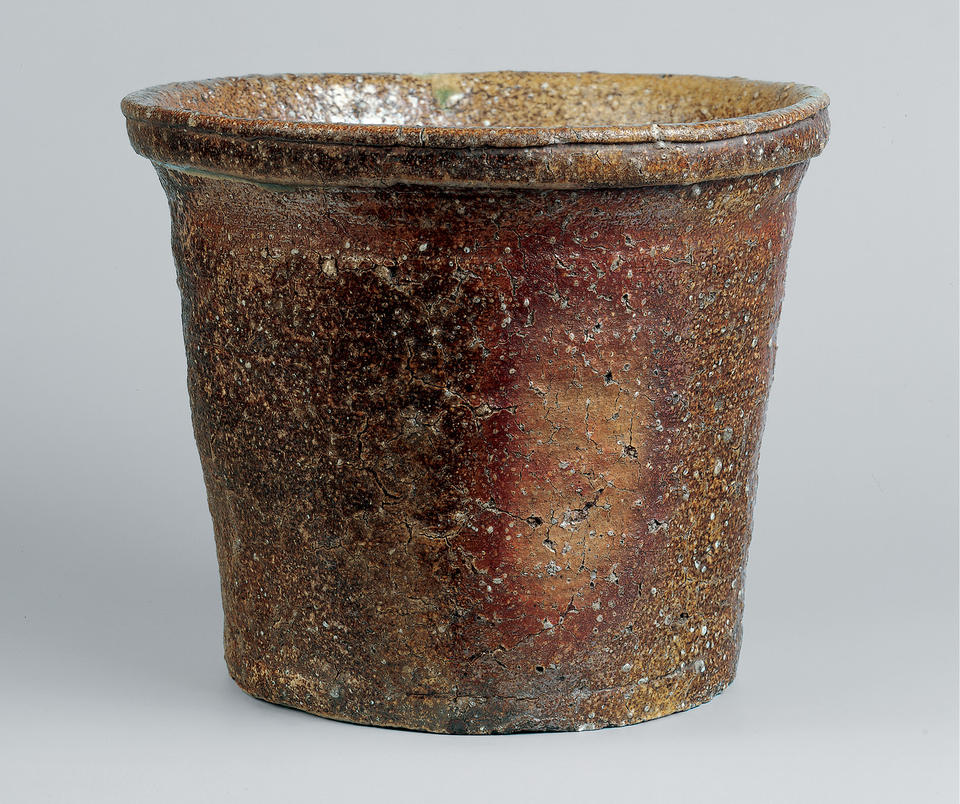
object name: freshwater jar mizusashi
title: Pail‑shaped freshwater jar (Onioke mizusashi)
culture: japanese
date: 1501-1600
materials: wood, glaze, stoneware